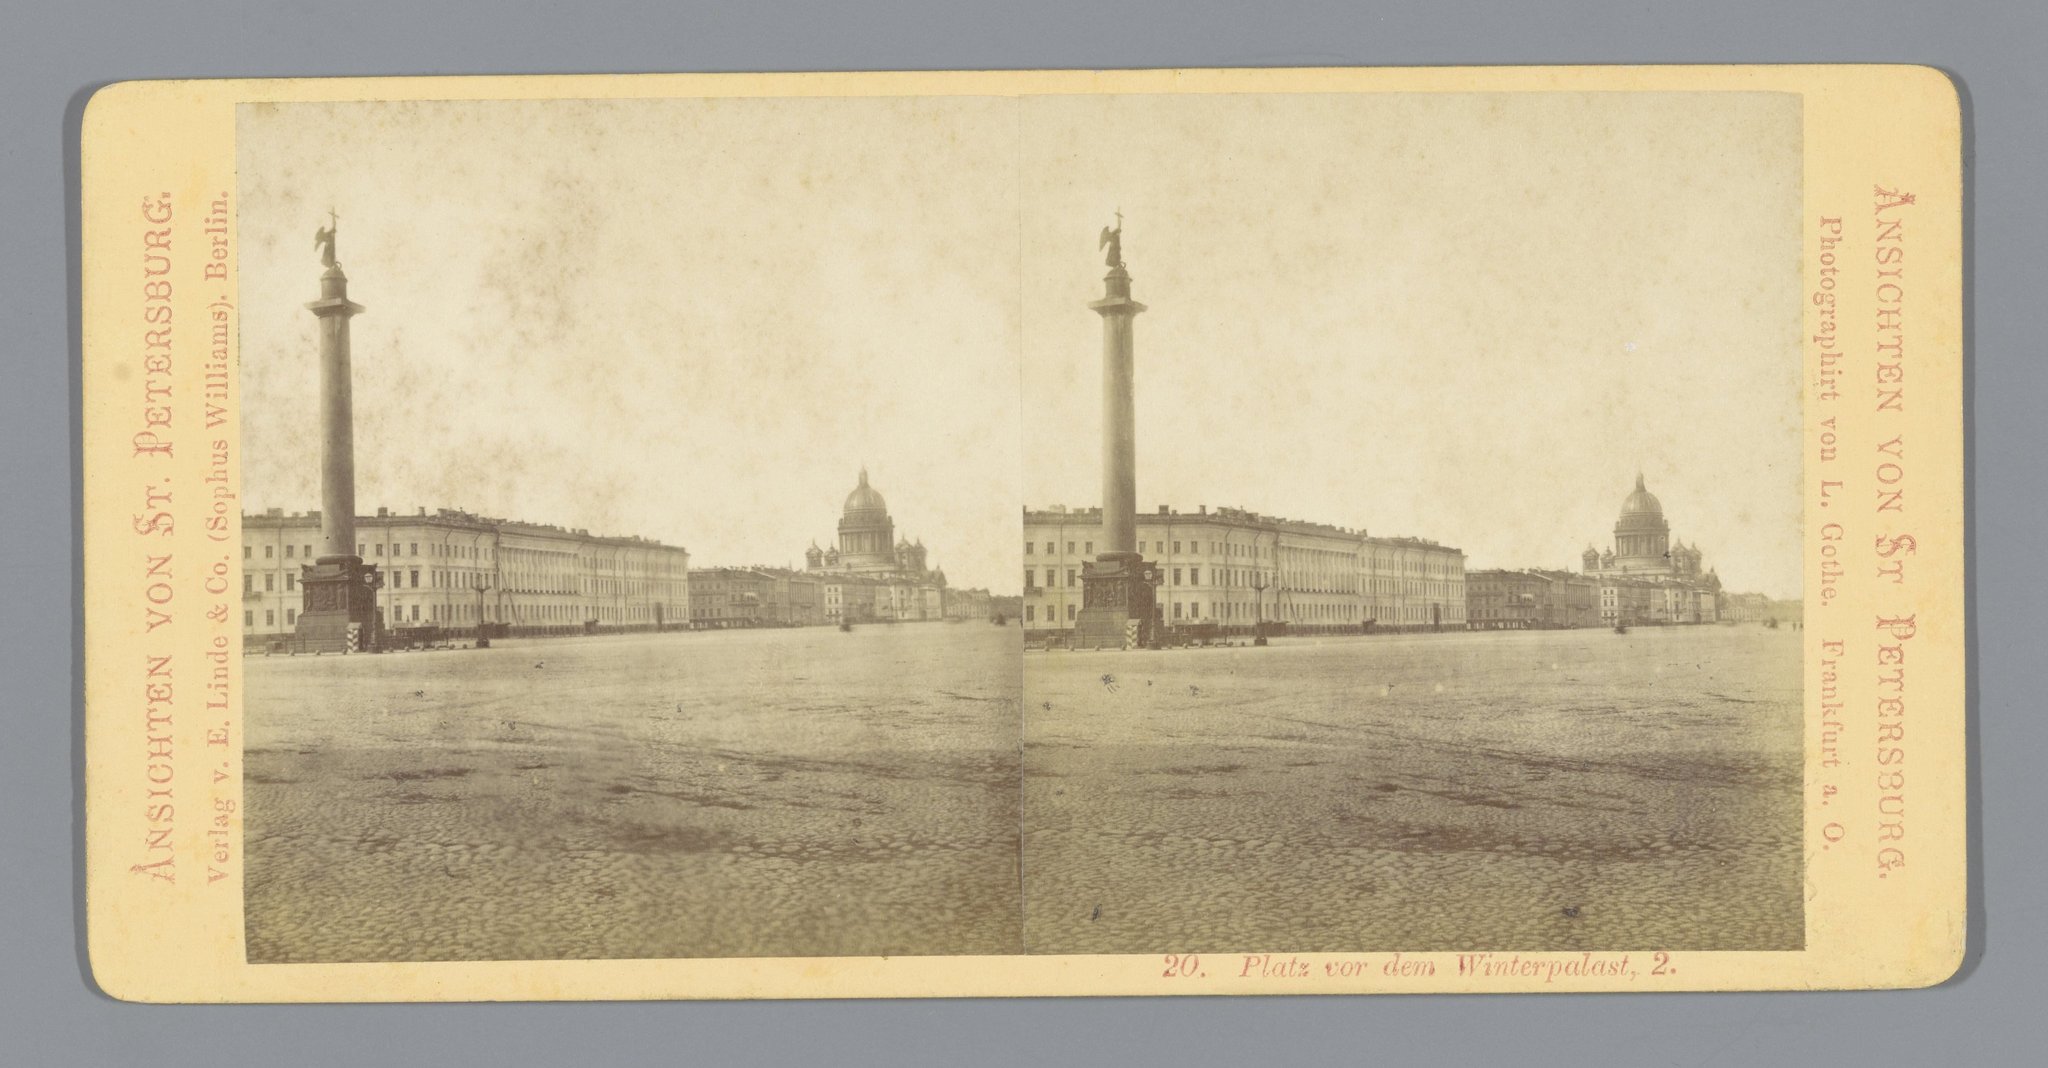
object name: stereograph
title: Gezicht op het Paleisplein in Sint-Petersburg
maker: louis gothe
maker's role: fotograaf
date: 1850-1880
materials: cardboard, photographic support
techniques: albumen print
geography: berlin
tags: square, place, circus, etc., monument, statue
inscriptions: inscription: ‘Ansichten von St. Petersburg.’, number: ‘20.’